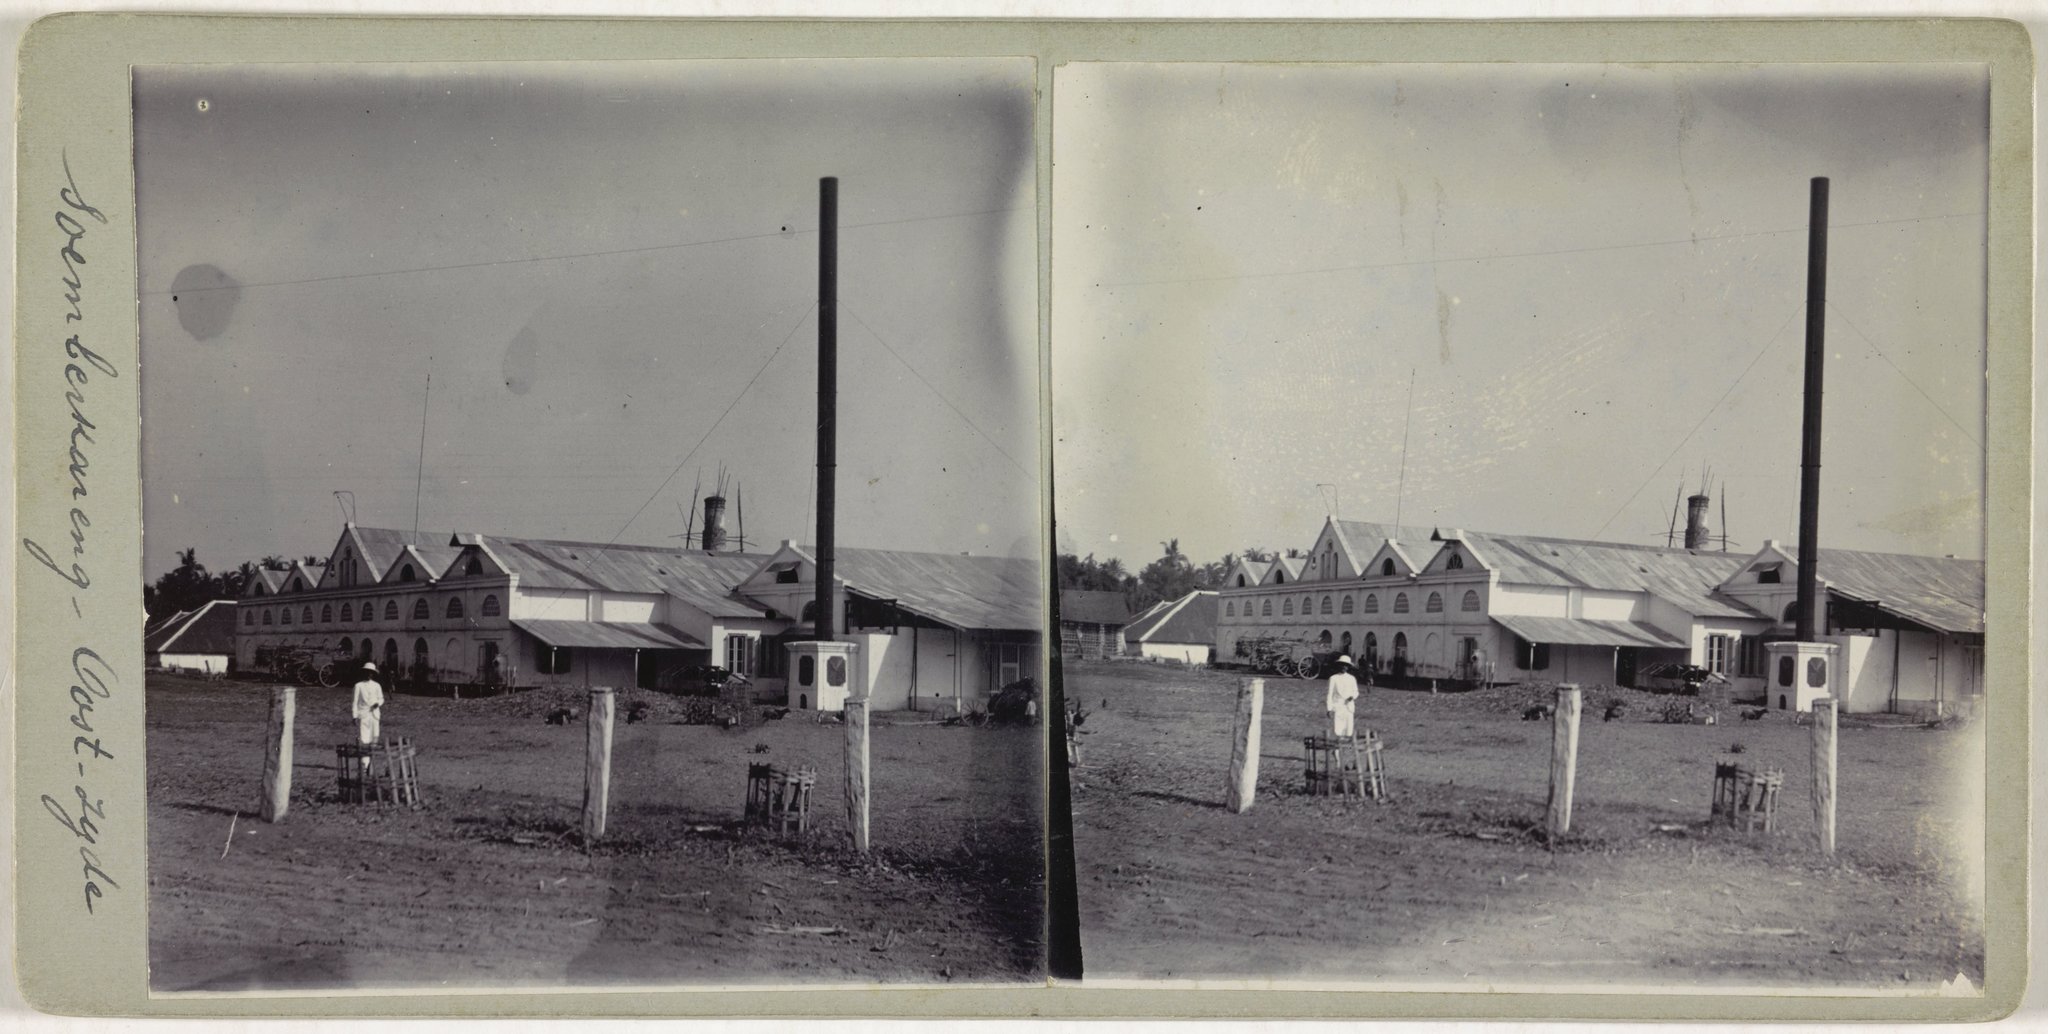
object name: stereograph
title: Oostzijde van suikerfabriek (?) Soemberkareng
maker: Anonymous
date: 1906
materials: cardboard, paper, photographic support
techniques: albumen print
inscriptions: title: ‘Soemberkareng - Oost-zijde’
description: Links staat een man, op de achtergrond is een suikerfabriek (?) zichtbaar.